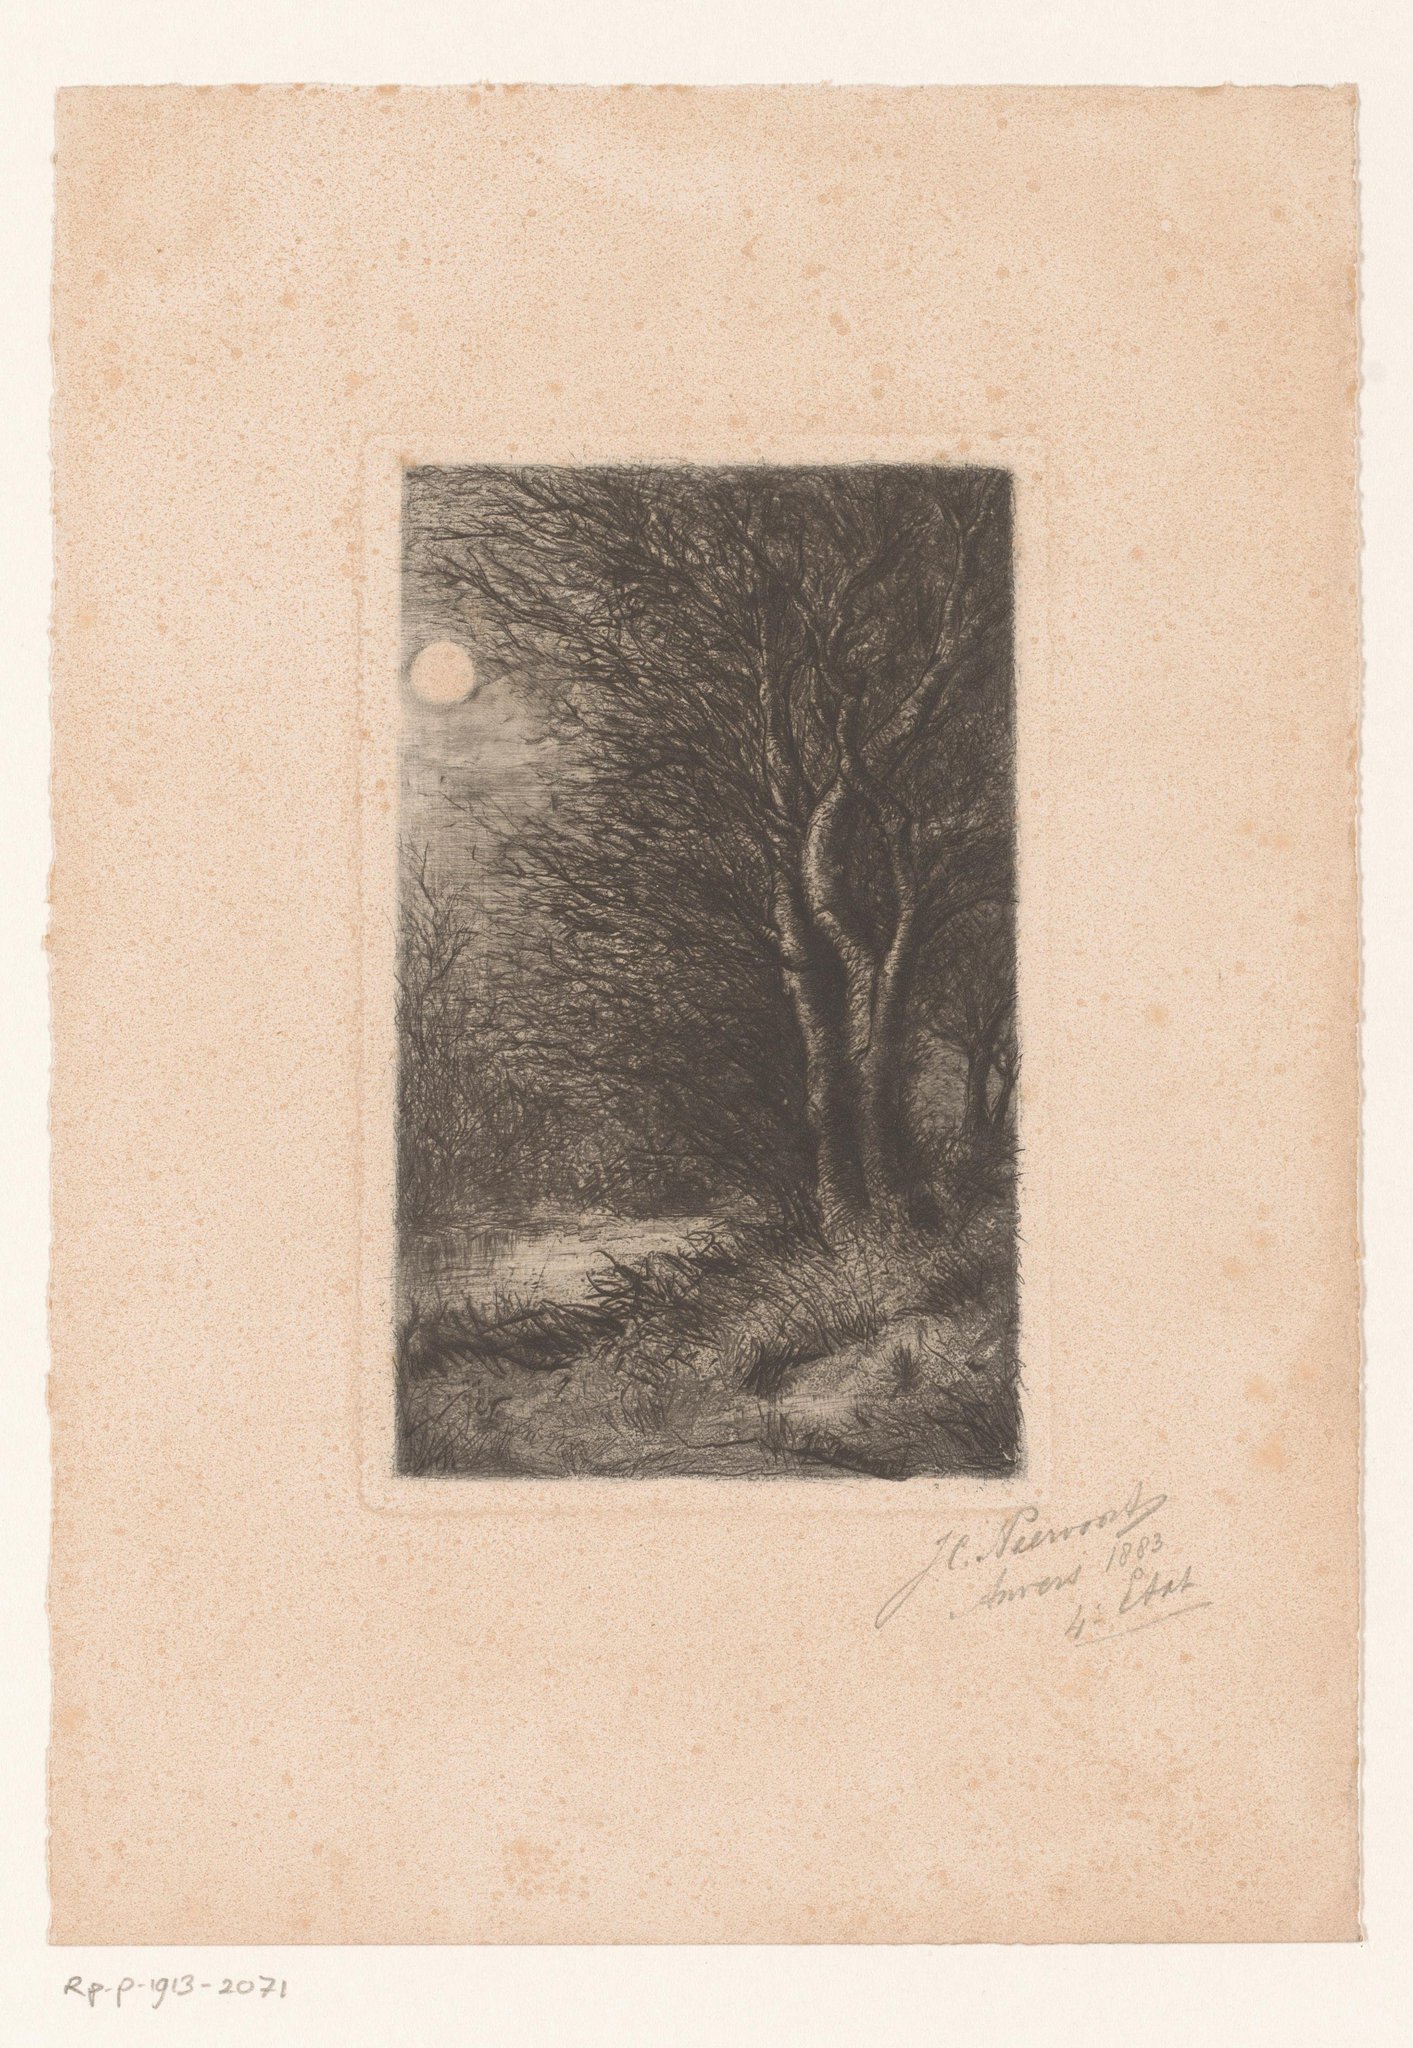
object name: print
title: Maanlandschap bij 's Hertogenbosch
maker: johannes cornelius neervoort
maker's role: print maker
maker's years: 1863-1940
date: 1883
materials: paper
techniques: drypoint, etching, intaglio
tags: full moon, landscapes with waters, waterscapes, seascapes (in the temperate zone), forest, wood, den bosch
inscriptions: inscription: ‘Anvers 1883, 4e Etat’, collector's mark: Lugt 2228